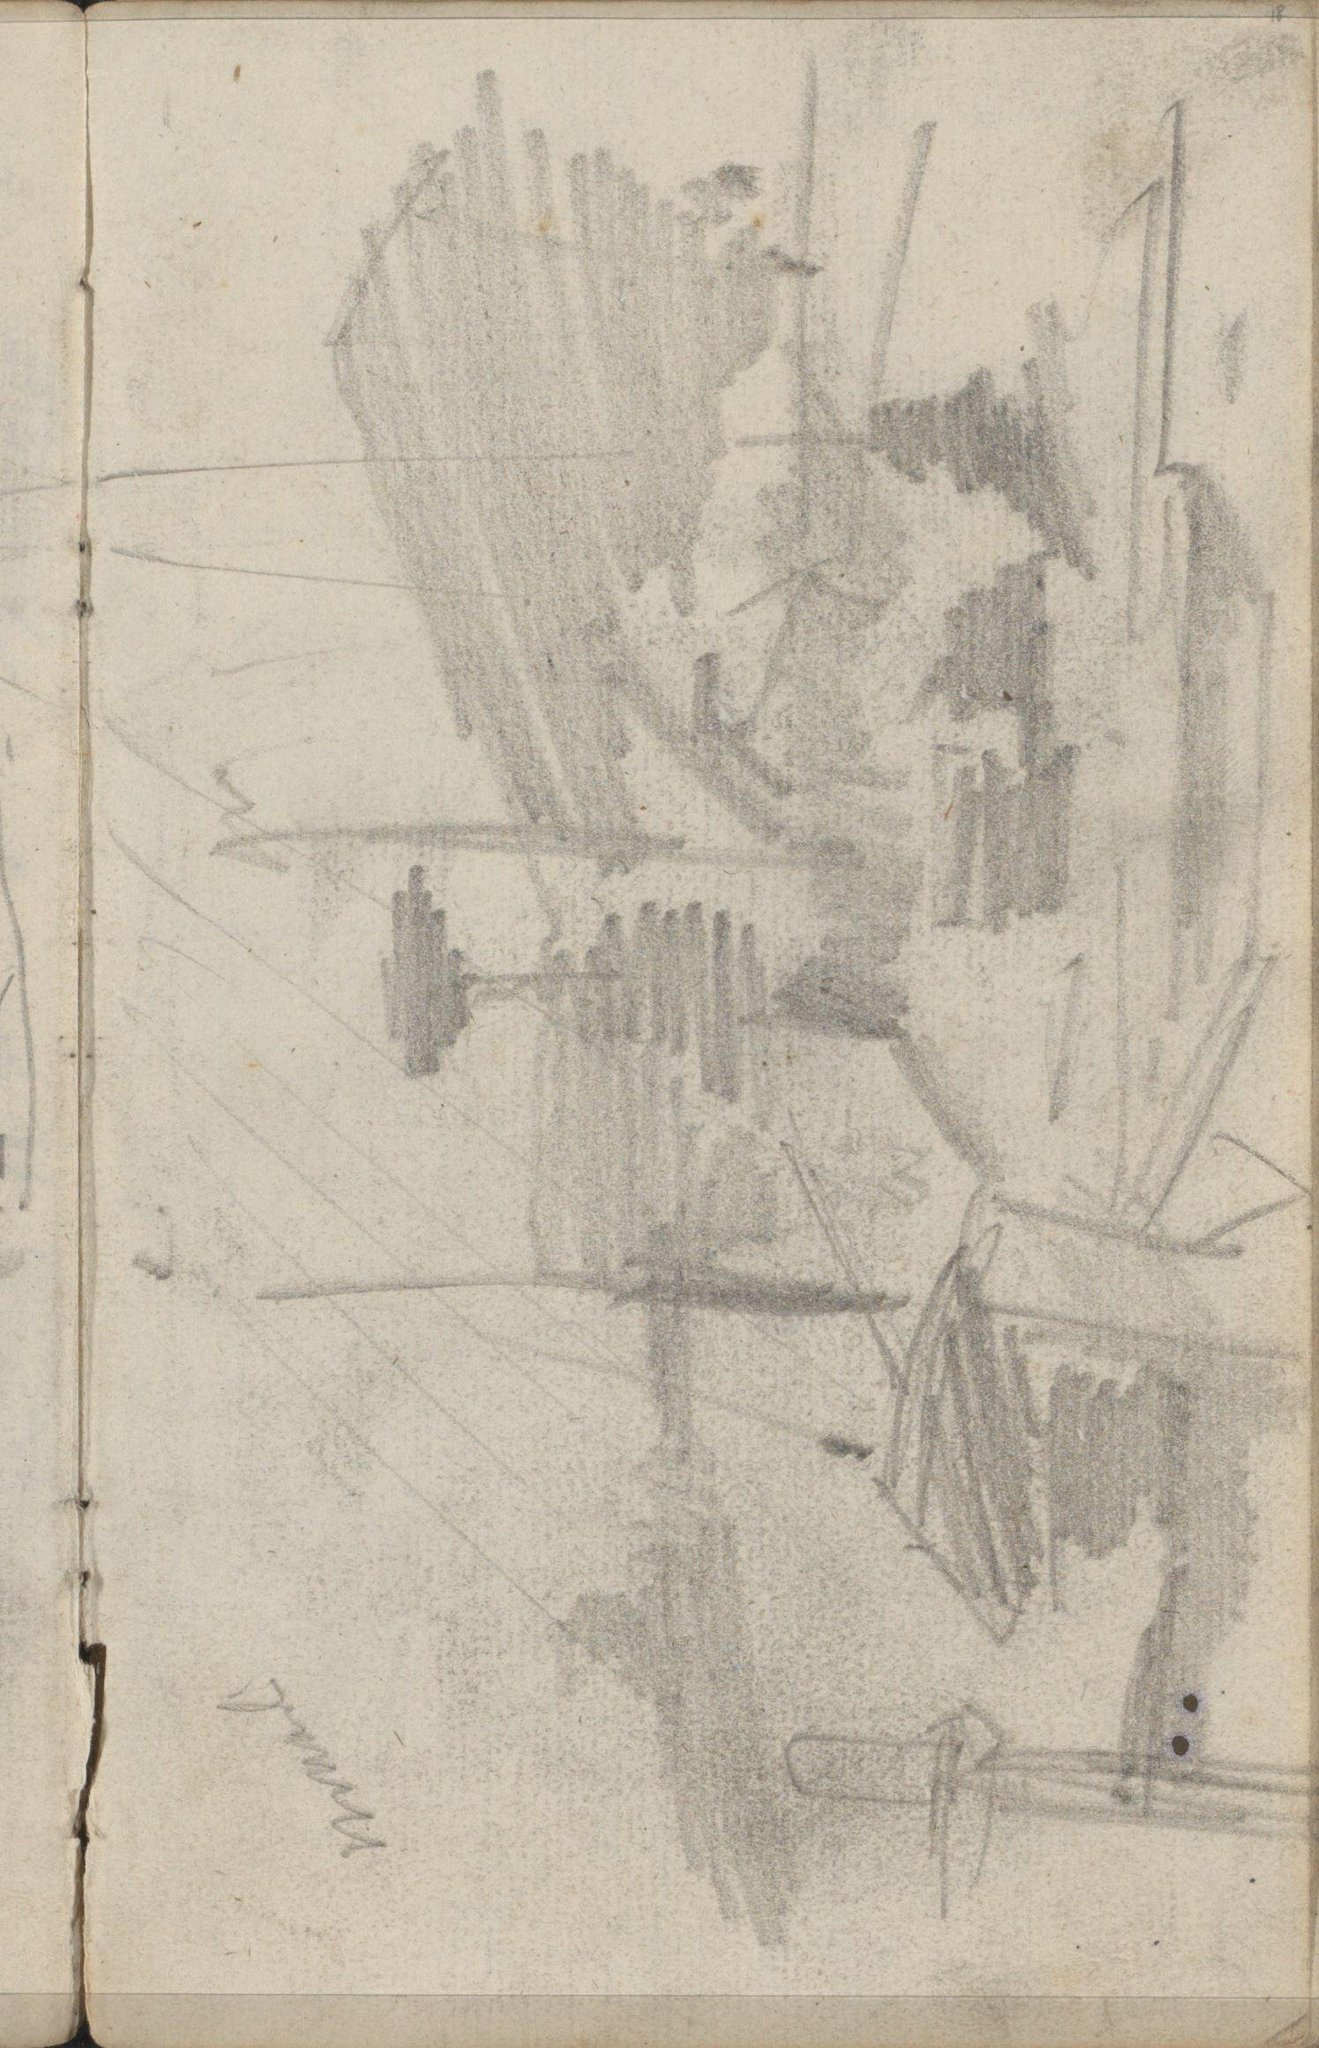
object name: sketchbook leaf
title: Aangemeerde boten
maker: george hendrik breitner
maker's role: draughtsman, painter, print maker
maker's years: 1857-1923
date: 1881-1883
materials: paper, pencil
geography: rotterdam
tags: ships (in general), water course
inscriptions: annotation: ‘Waal[?]’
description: Pagina 18 uit een schetsboek met 27 bladen